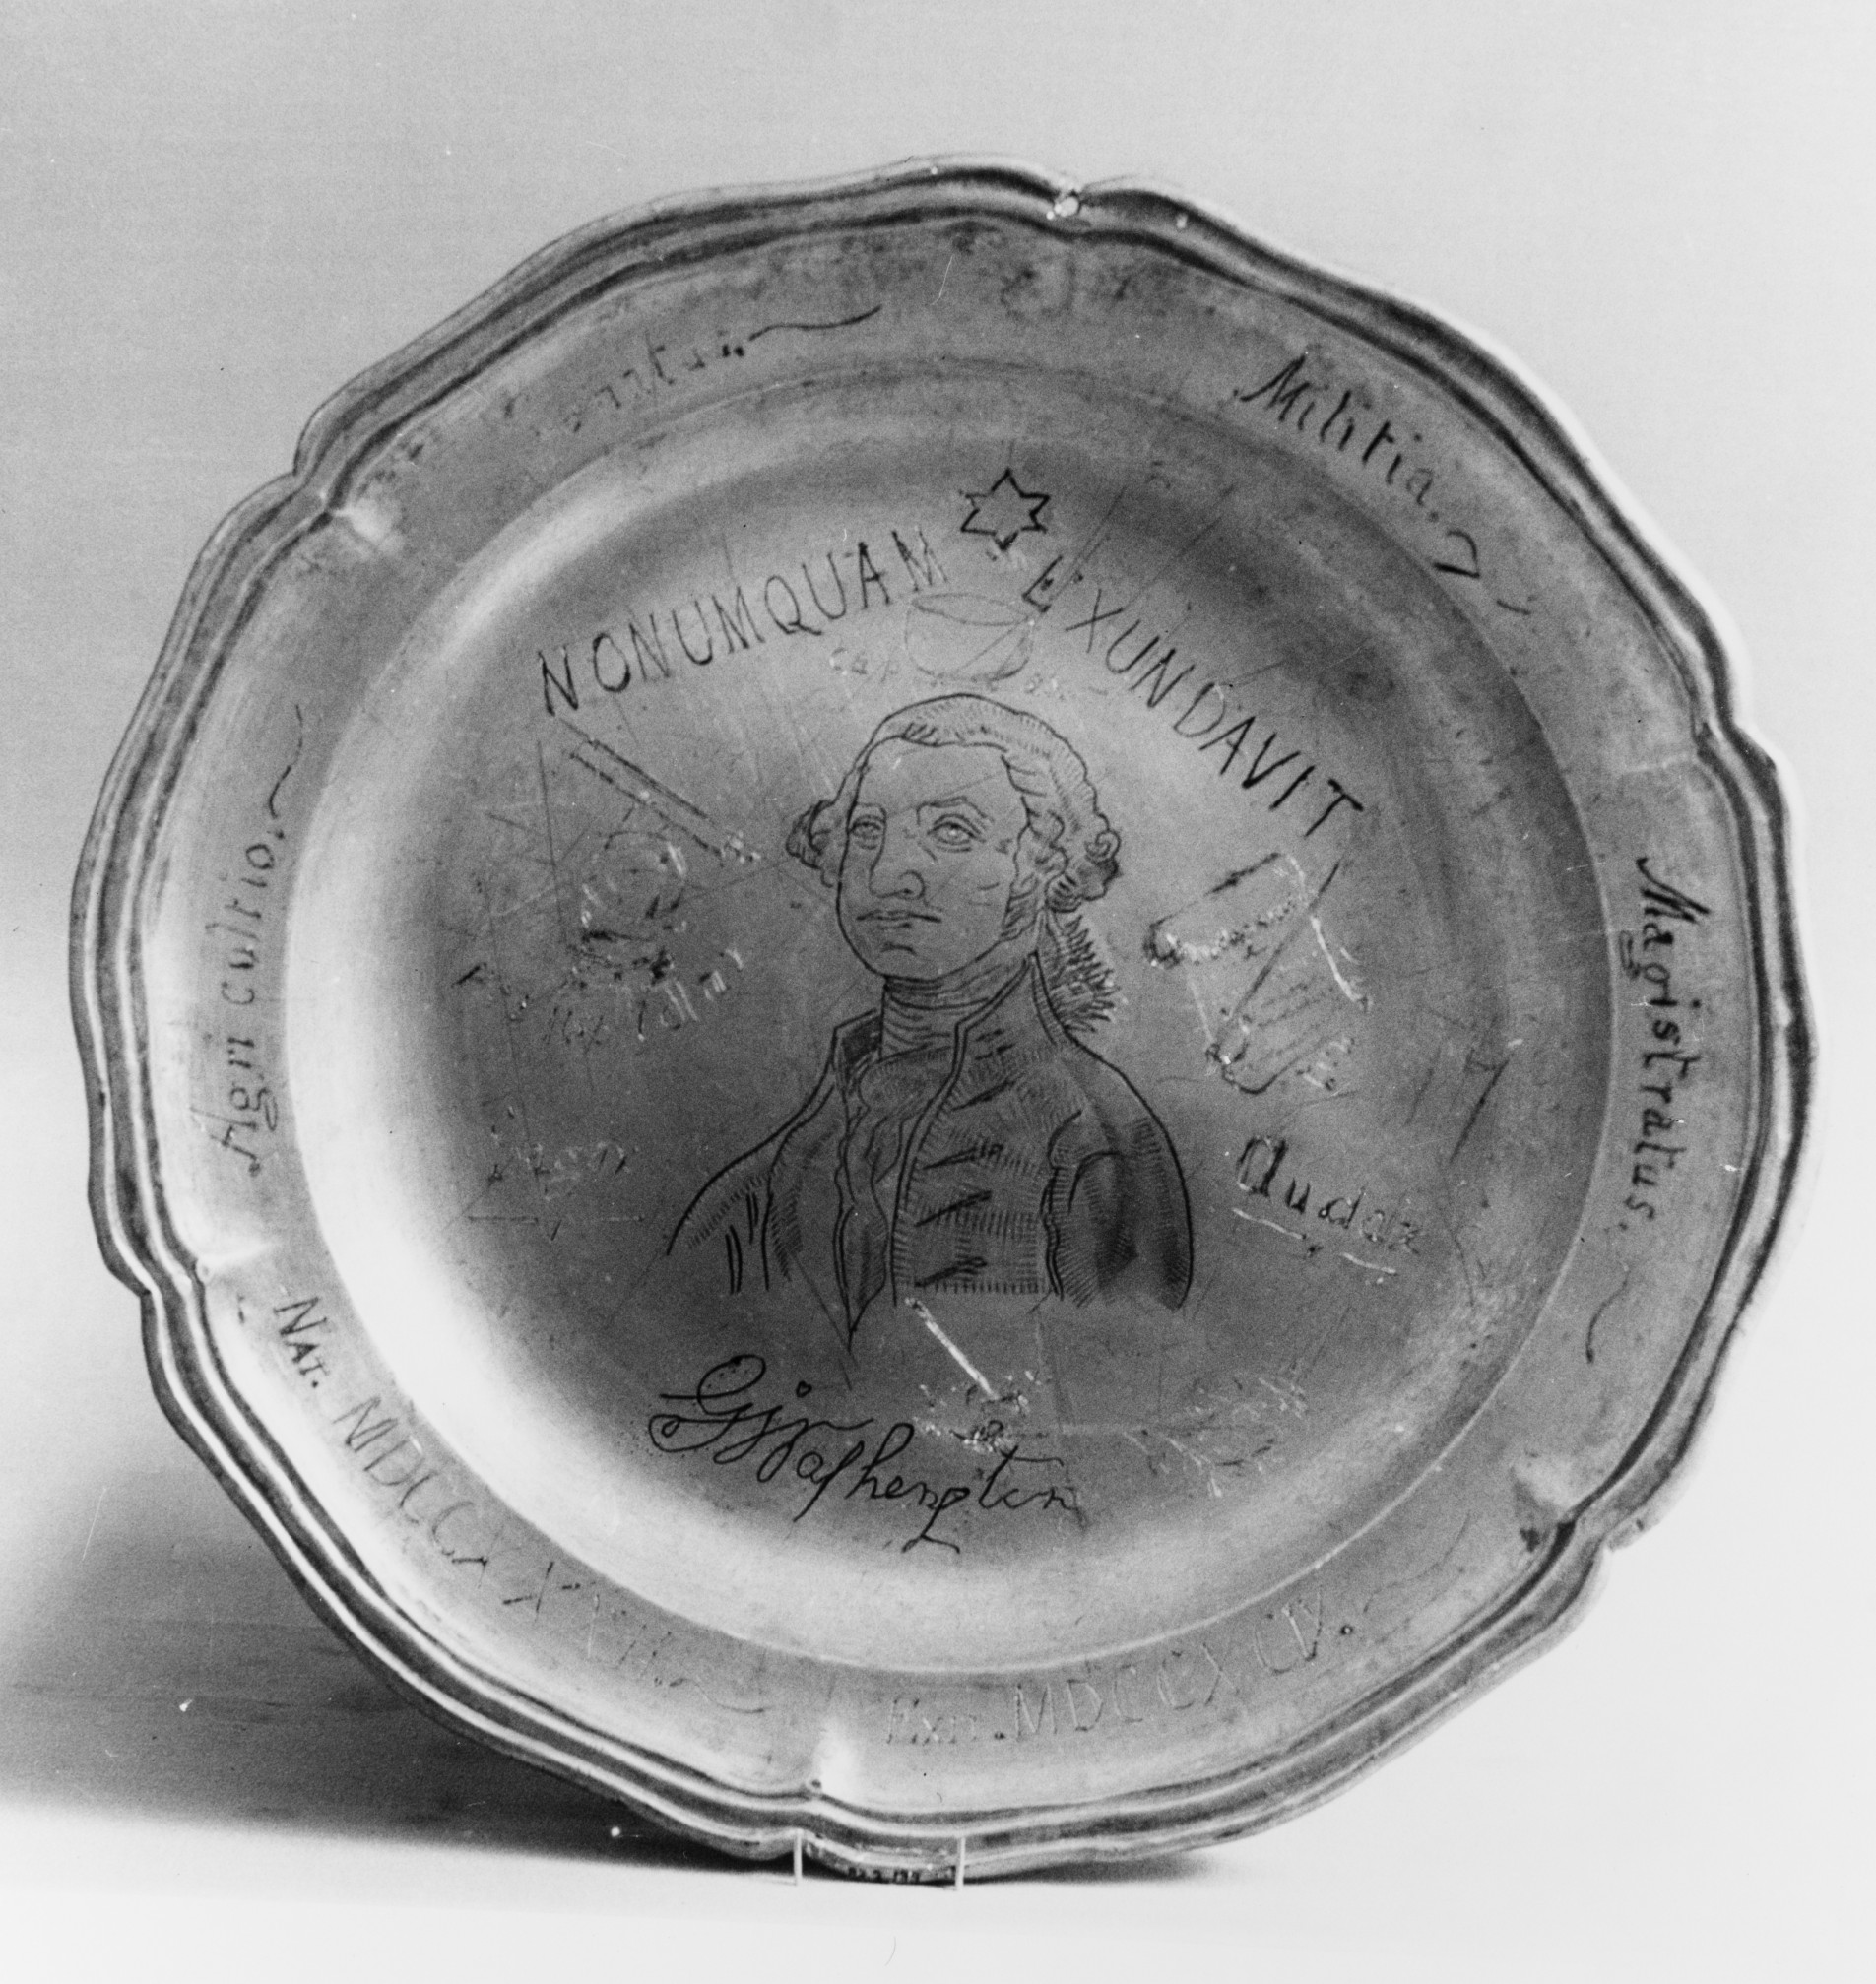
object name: plate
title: Engraved Plate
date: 1800-1883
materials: pewter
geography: france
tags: george washington,men